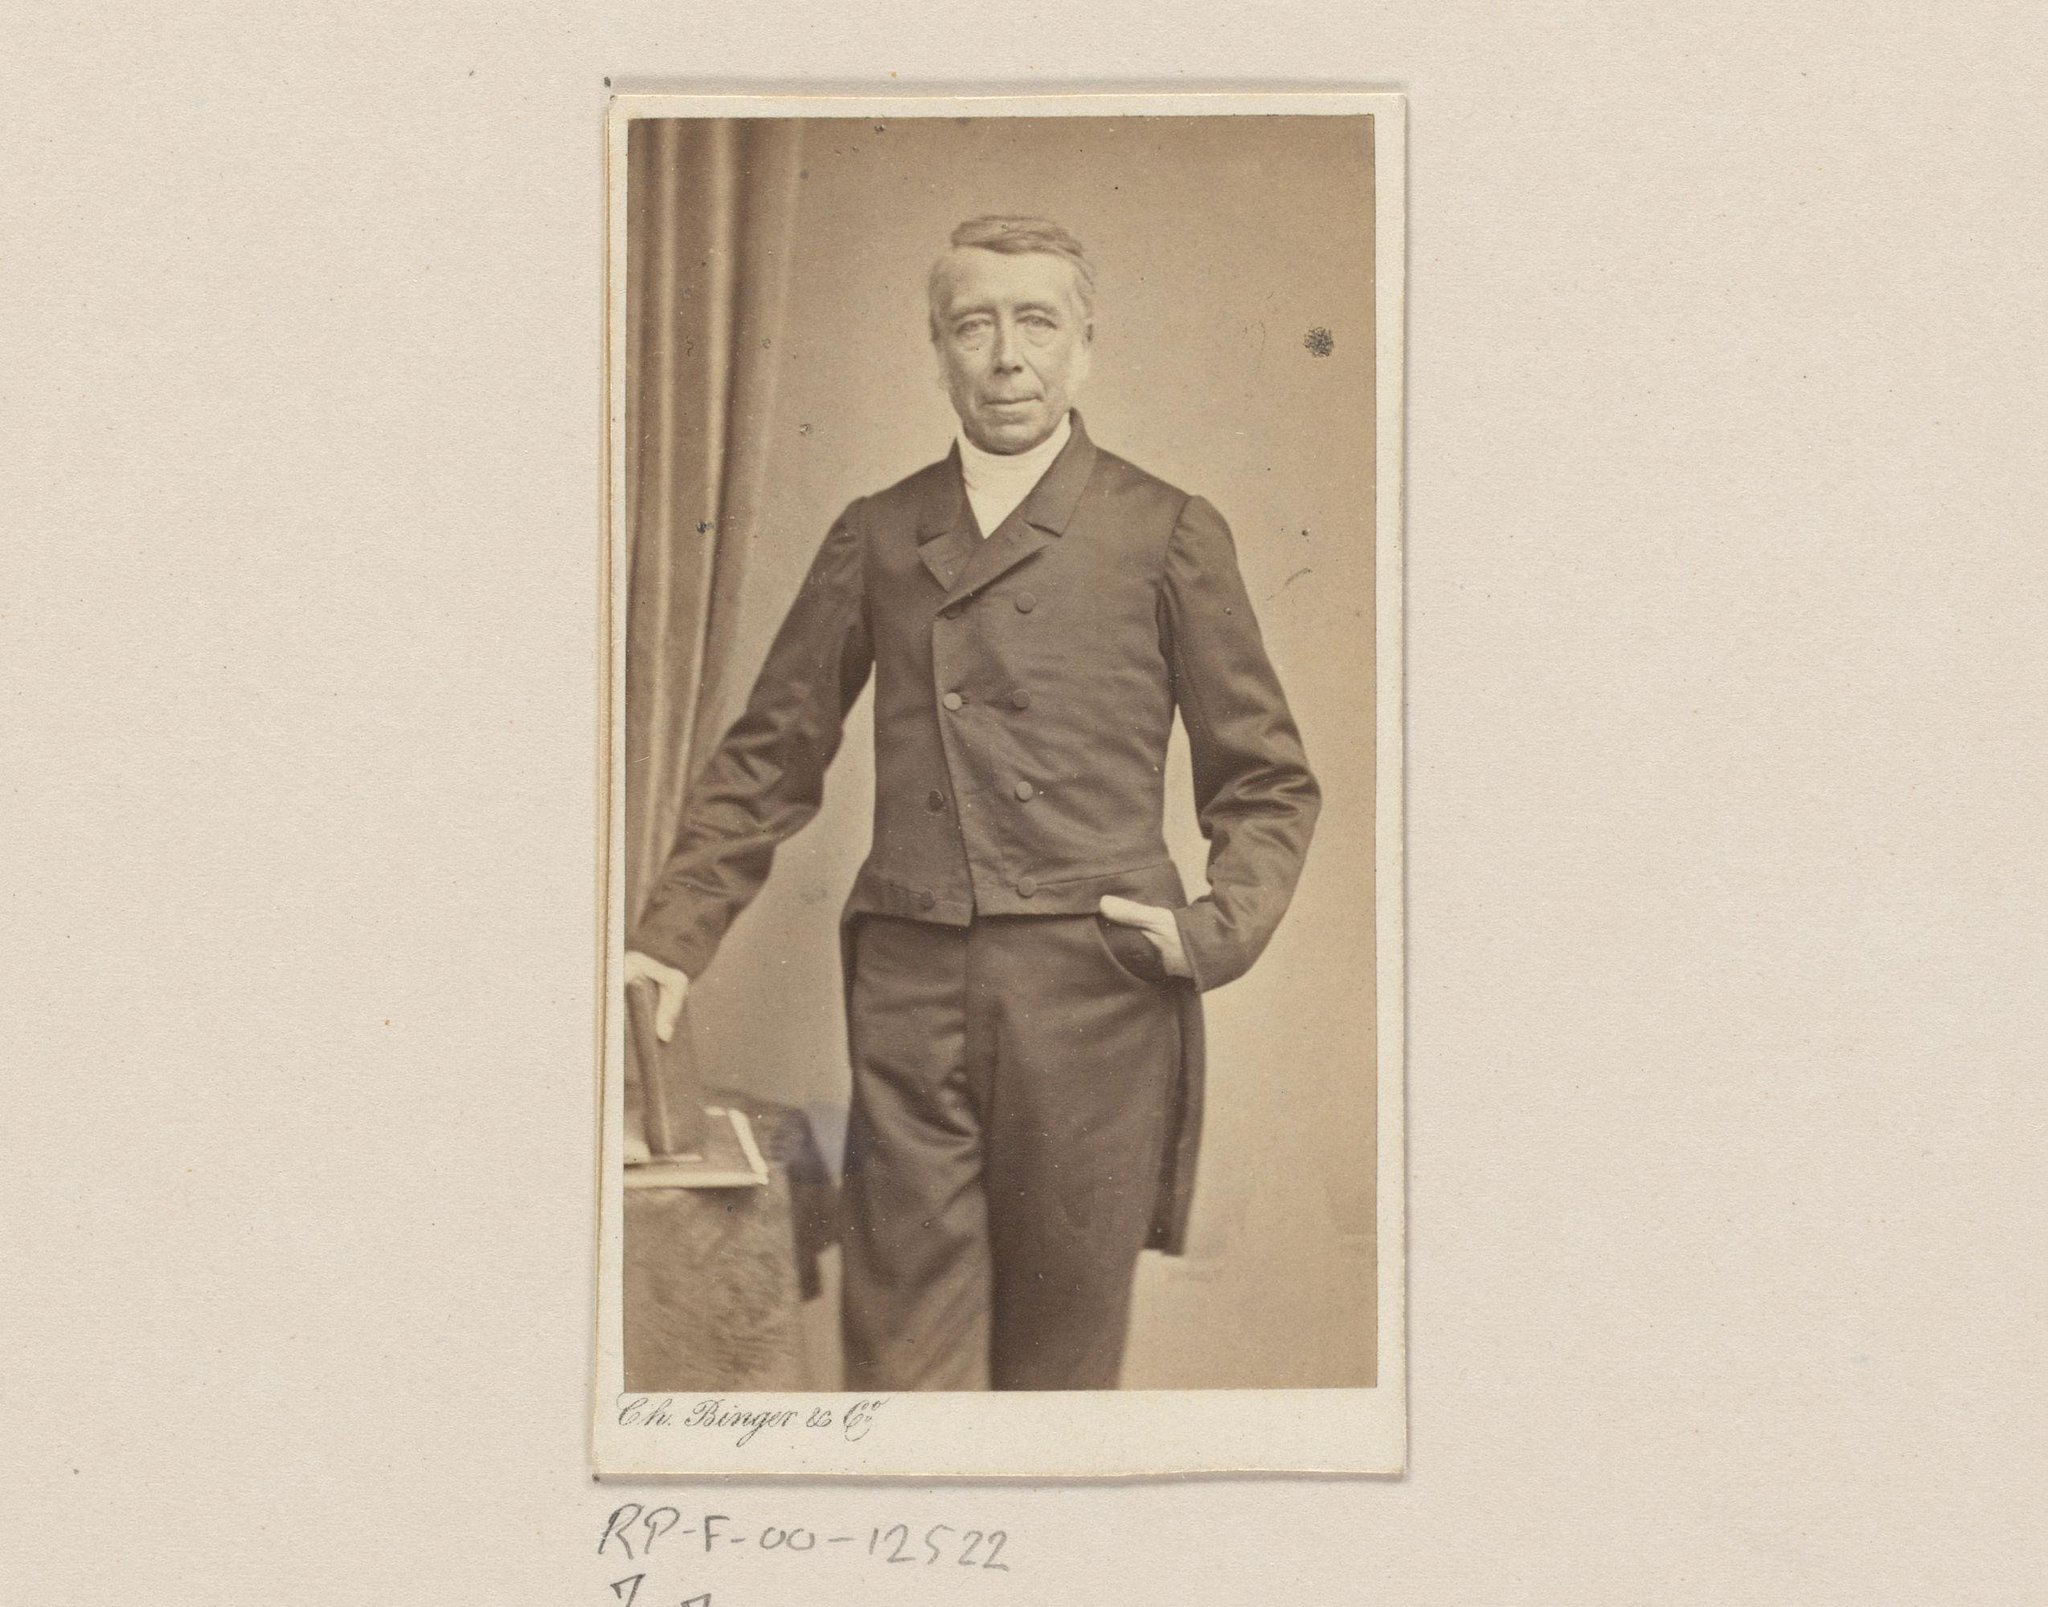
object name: photograph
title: Portret van Willem Carel Mauve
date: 1862-1869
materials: cardboard, paper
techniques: albumen print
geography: haarlem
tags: haarlem, historical persons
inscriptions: address: ‘Zylstraat, HAARLEM.’